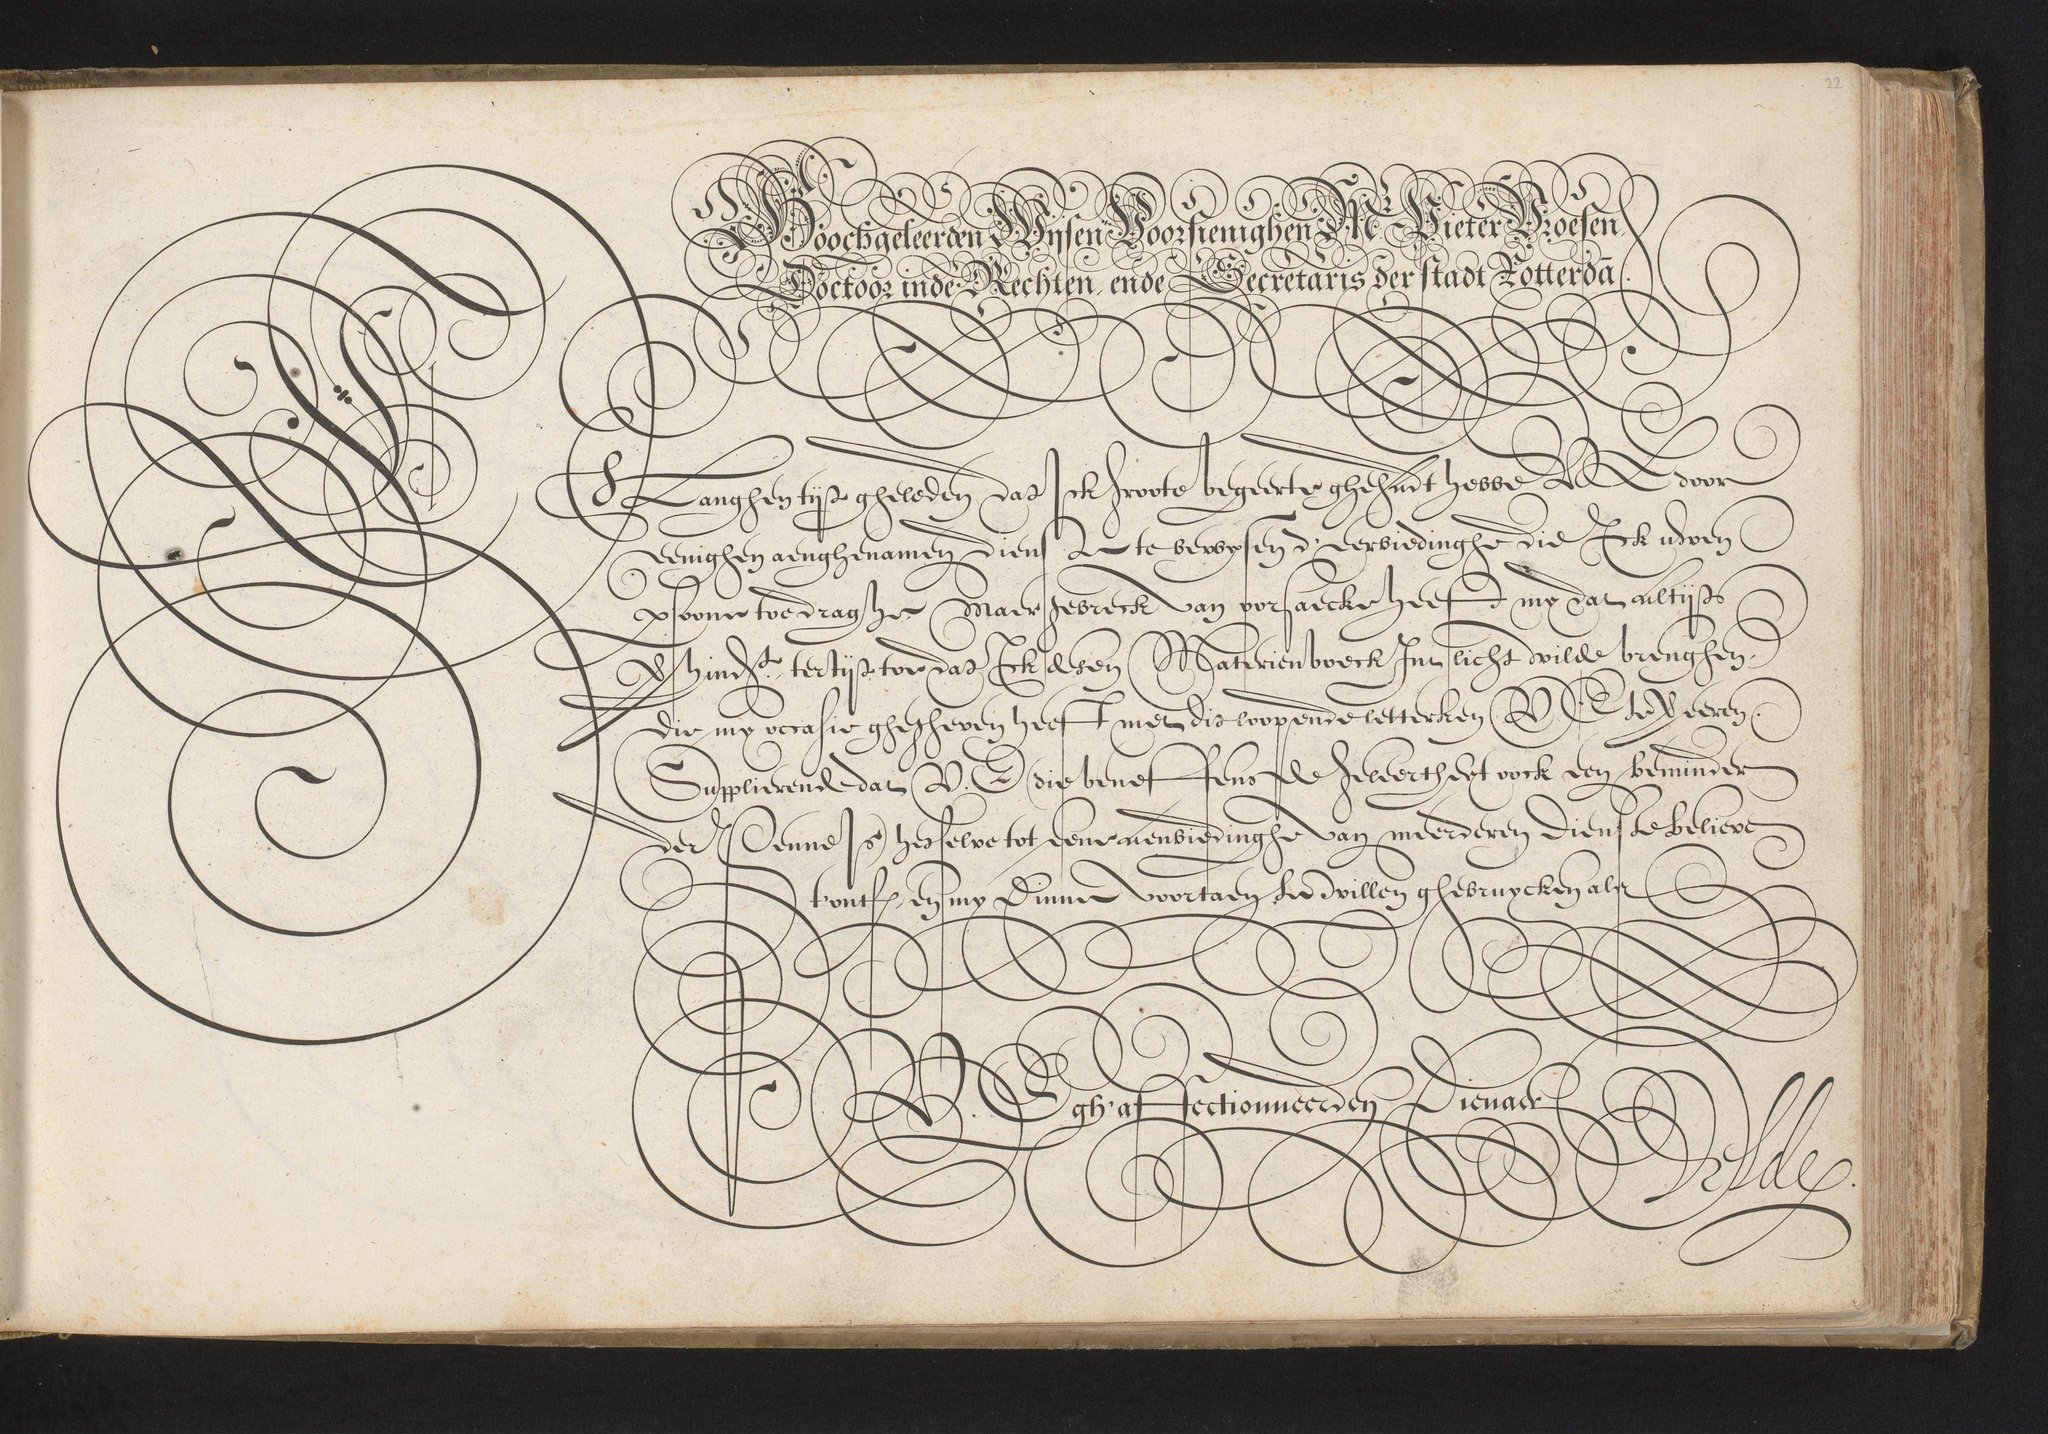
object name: ornament print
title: Schrijfvoorbeeld: Hoochgeleerden Wijsen (...)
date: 1605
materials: paper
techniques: engraving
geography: haarlem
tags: calligraphy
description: Schrijfvoorbeeld met de aanhef: Hoochgeleerden Wijsen Voorsienighen Mr Pieter Vroesen, Doctoor inde Rechten ende Secretaris der stadt Rotterda(m). Daaronder in een andere letter een geornamenteerde initiaal en acht regels tekst in het Nederlands. De tekst is omlijst door krulwerk. De prent maakt deel uit van een album.